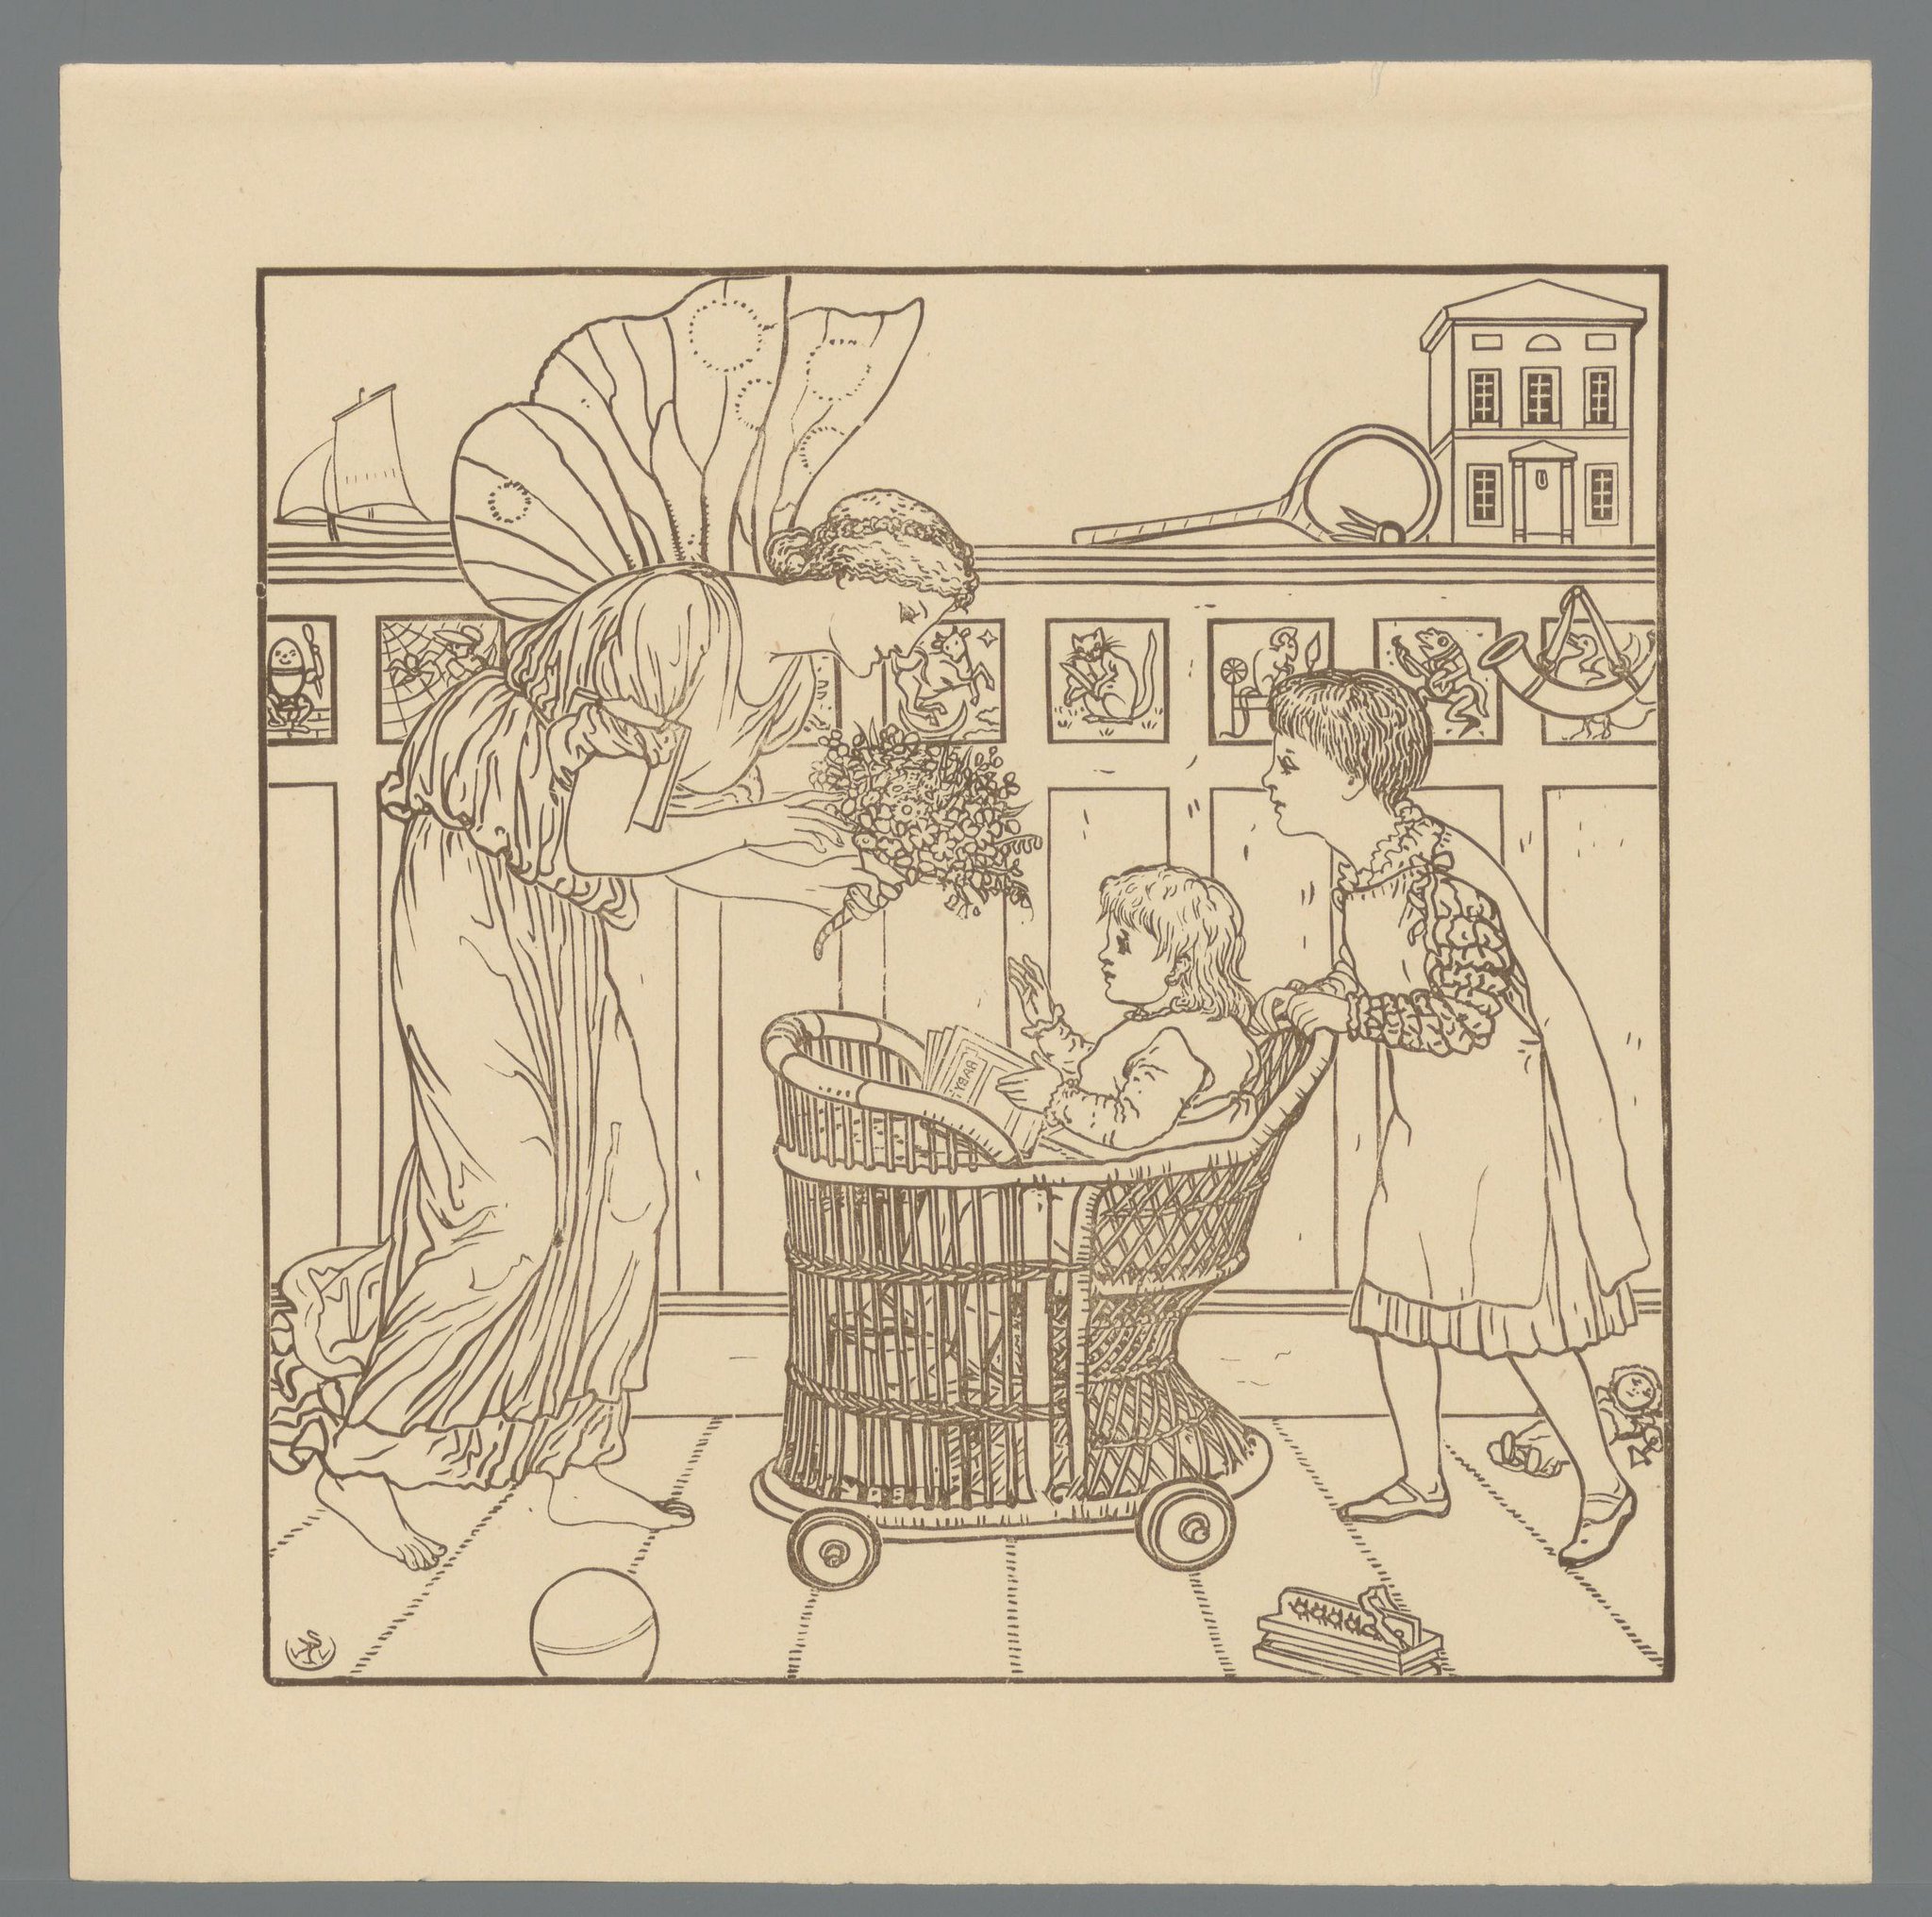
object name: print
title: Fee geeft bloemen aan een kind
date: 1887-1927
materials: paper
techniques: engraving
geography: london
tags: cut flowers; nosegay, bunch of flowers, fairy - aa - female human figure, child (+ two persons)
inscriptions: collector's mark: Lugt 2228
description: Prent uit: Walter Crane's painting book. Londen: Routledge & Sons, 1887. Of een latere uitgave. Dit boek bevat twaalf voorstellingen die in kleur en lijntekening zijn gedrukt om te gebruiken als (in)kleurboek. De voorstellingen zijn afkomstig uit eerdere werken van Crane.